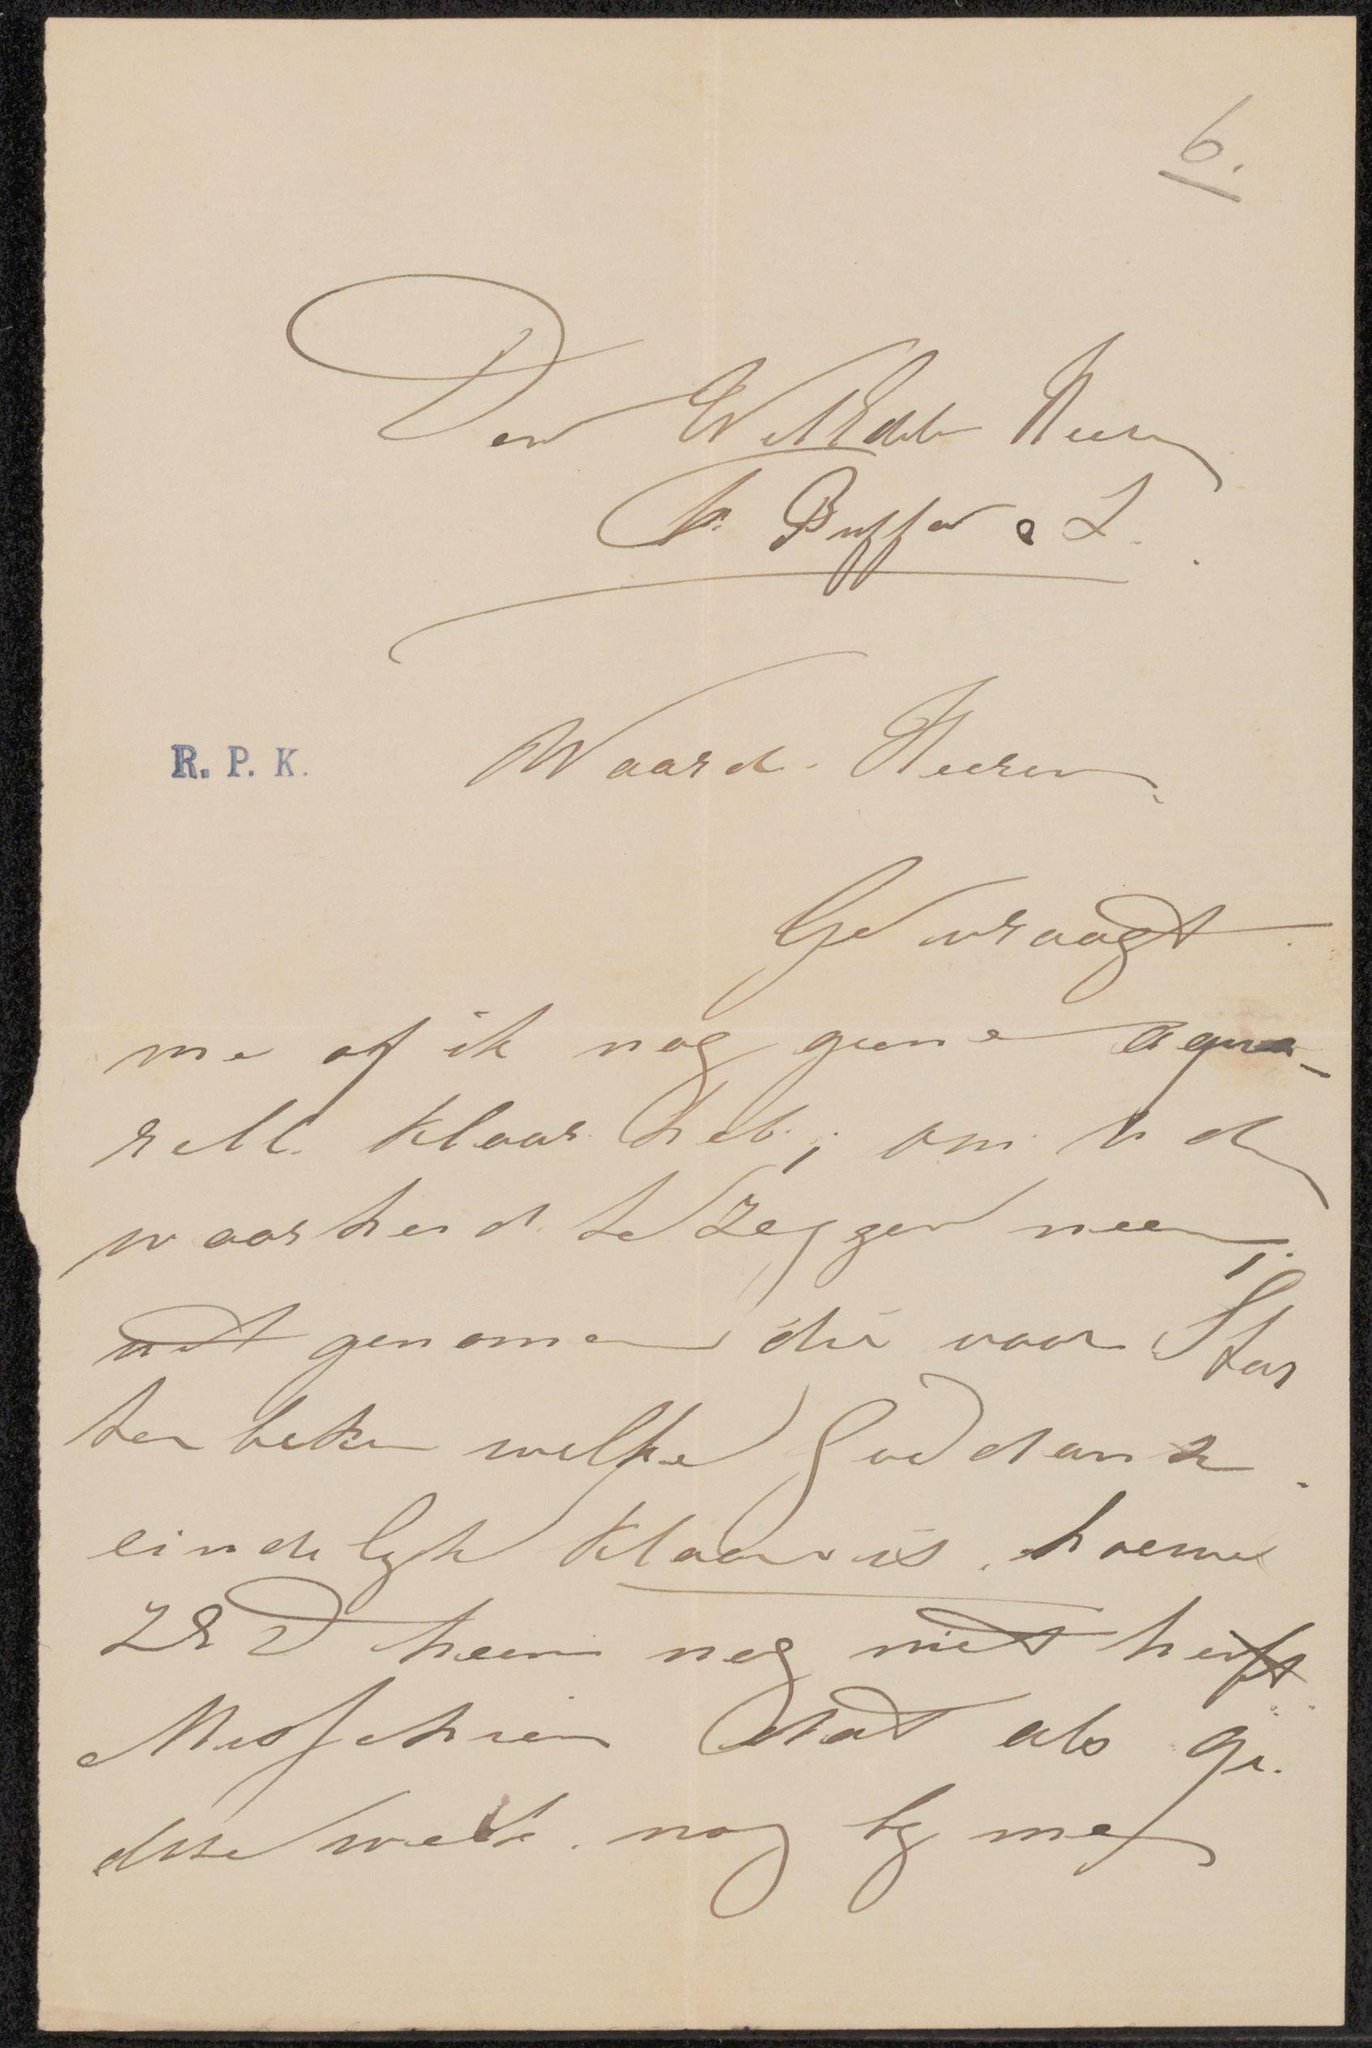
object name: letter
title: Brief aan Frans Buffa en Zonen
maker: willem maris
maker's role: draughtsman, painter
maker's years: 1844-1910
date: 1854-1910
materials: ink, paper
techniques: pen, writing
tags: publisher, art trade, art shop, drawing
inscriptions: collector's mark: Lugt 2228, collector's mark: Lugt 2233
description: Brief gedateerd 'vóór augustus 1873 (?)' in latere hand.